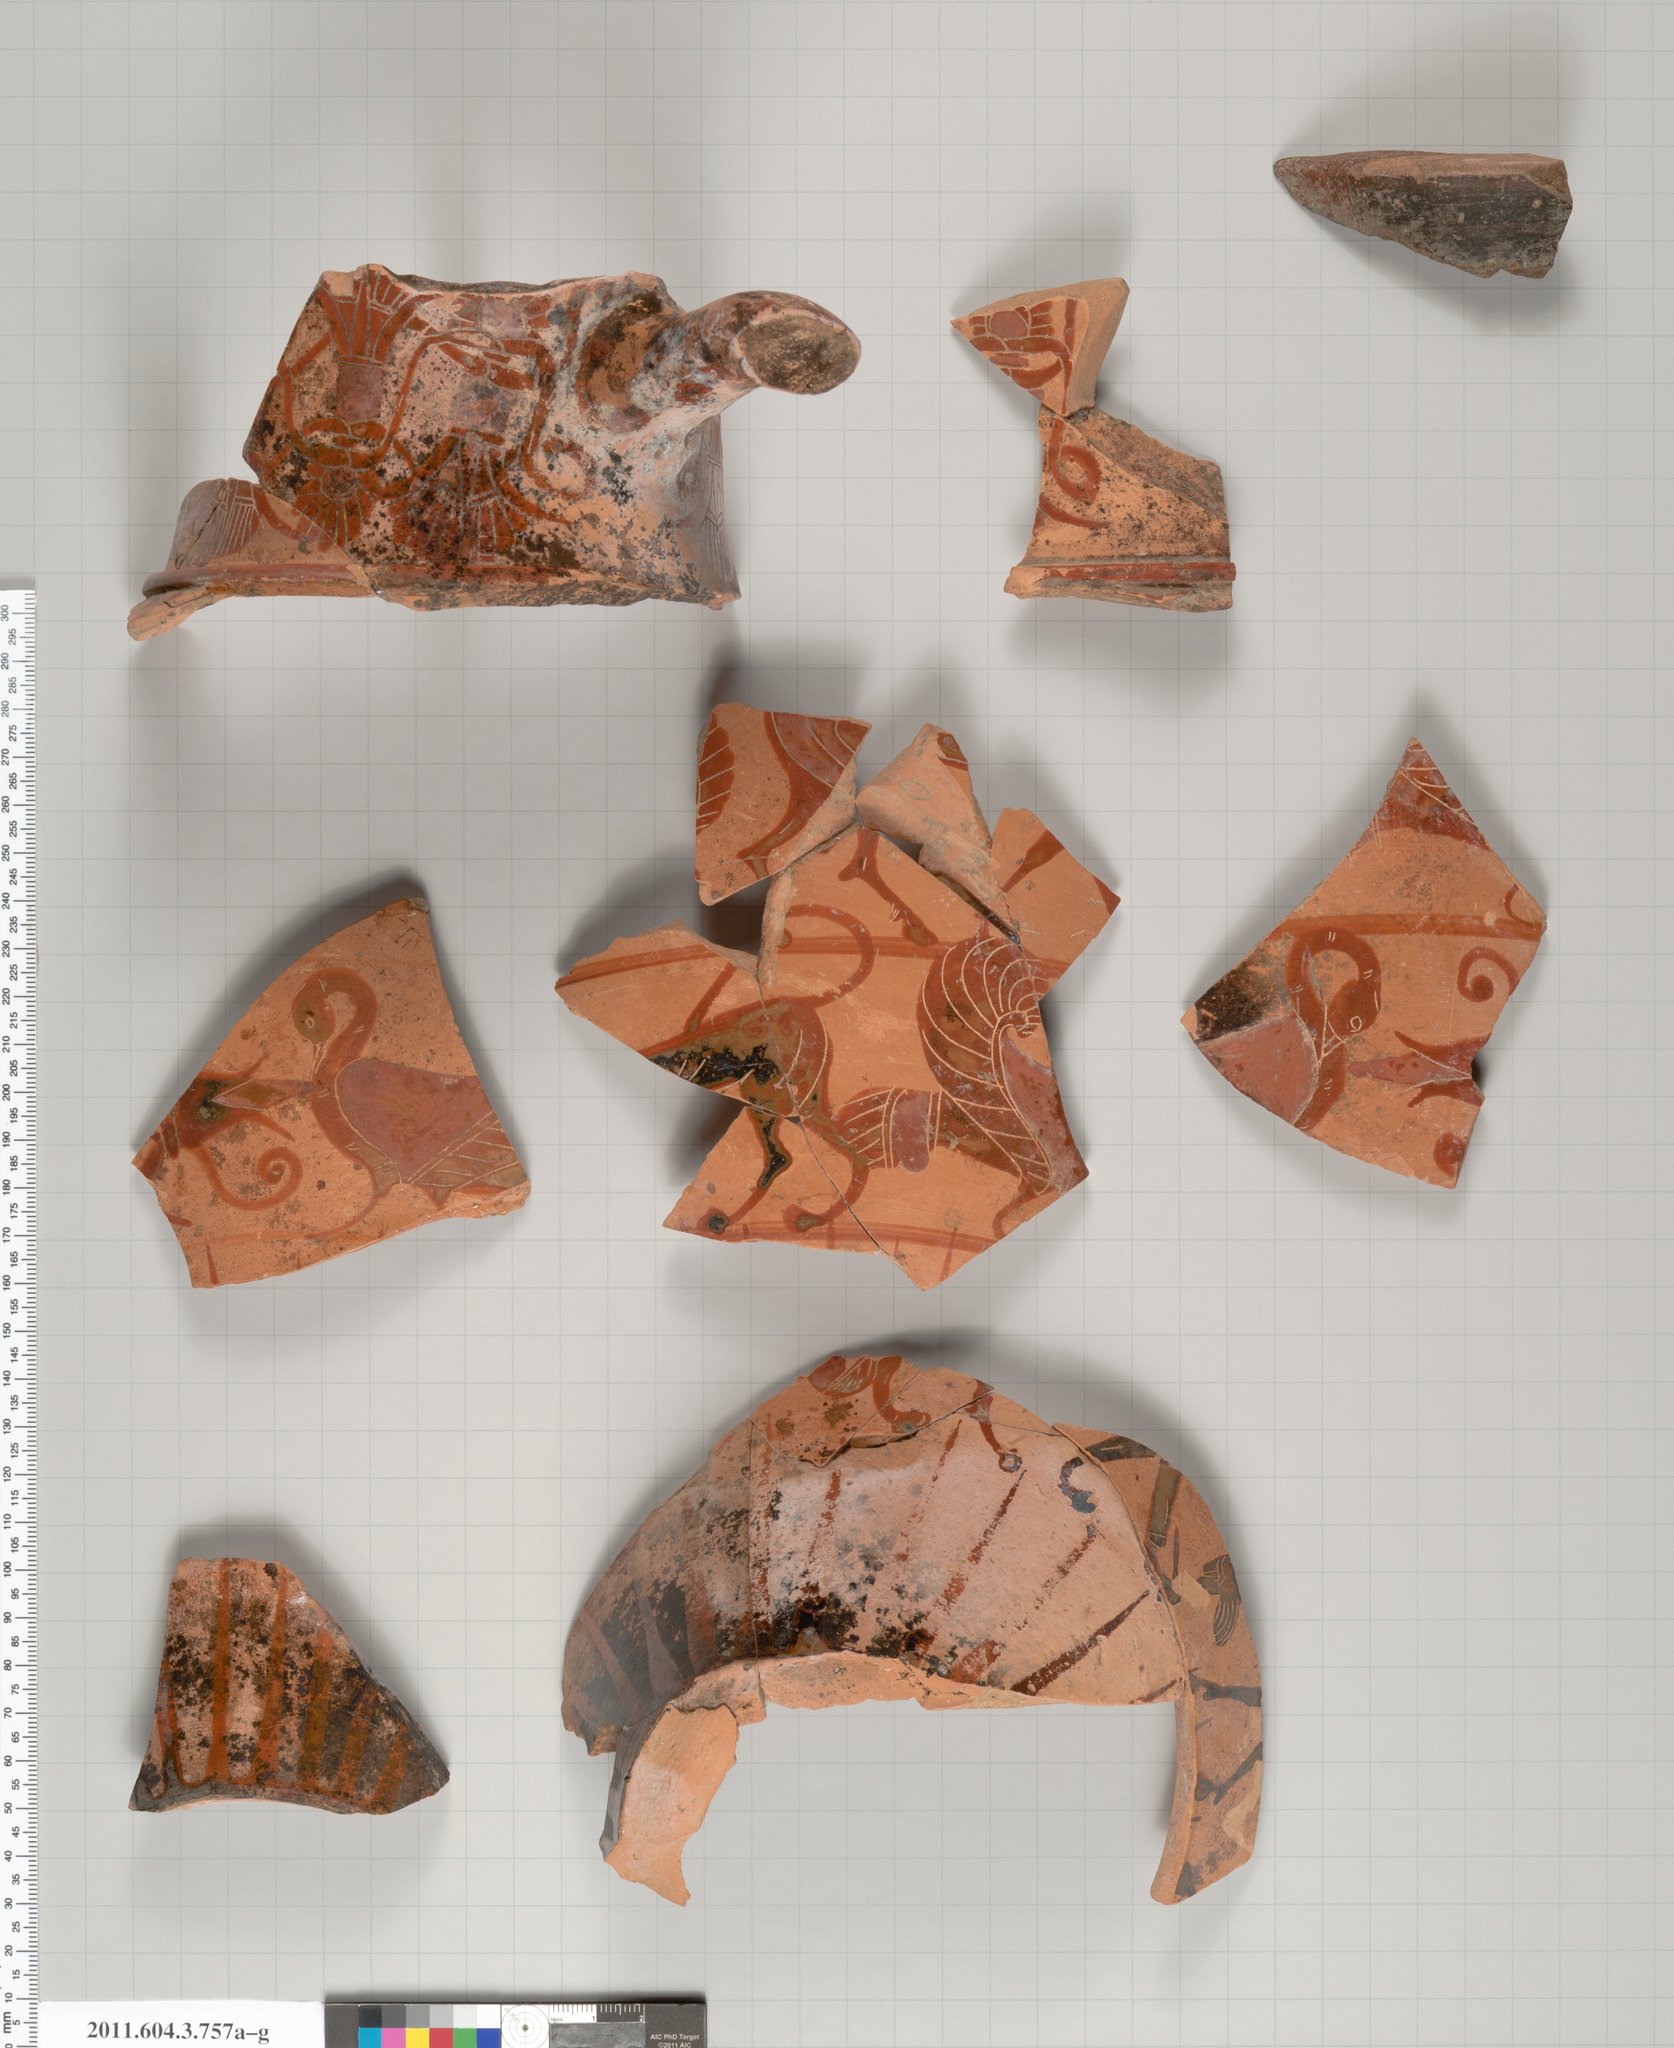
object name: neck amphora, tyrrhenian fragment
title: Terracotta fragments of a neck-amphora (jar)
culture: greek, attic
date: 575-551 BCE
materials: terracotta